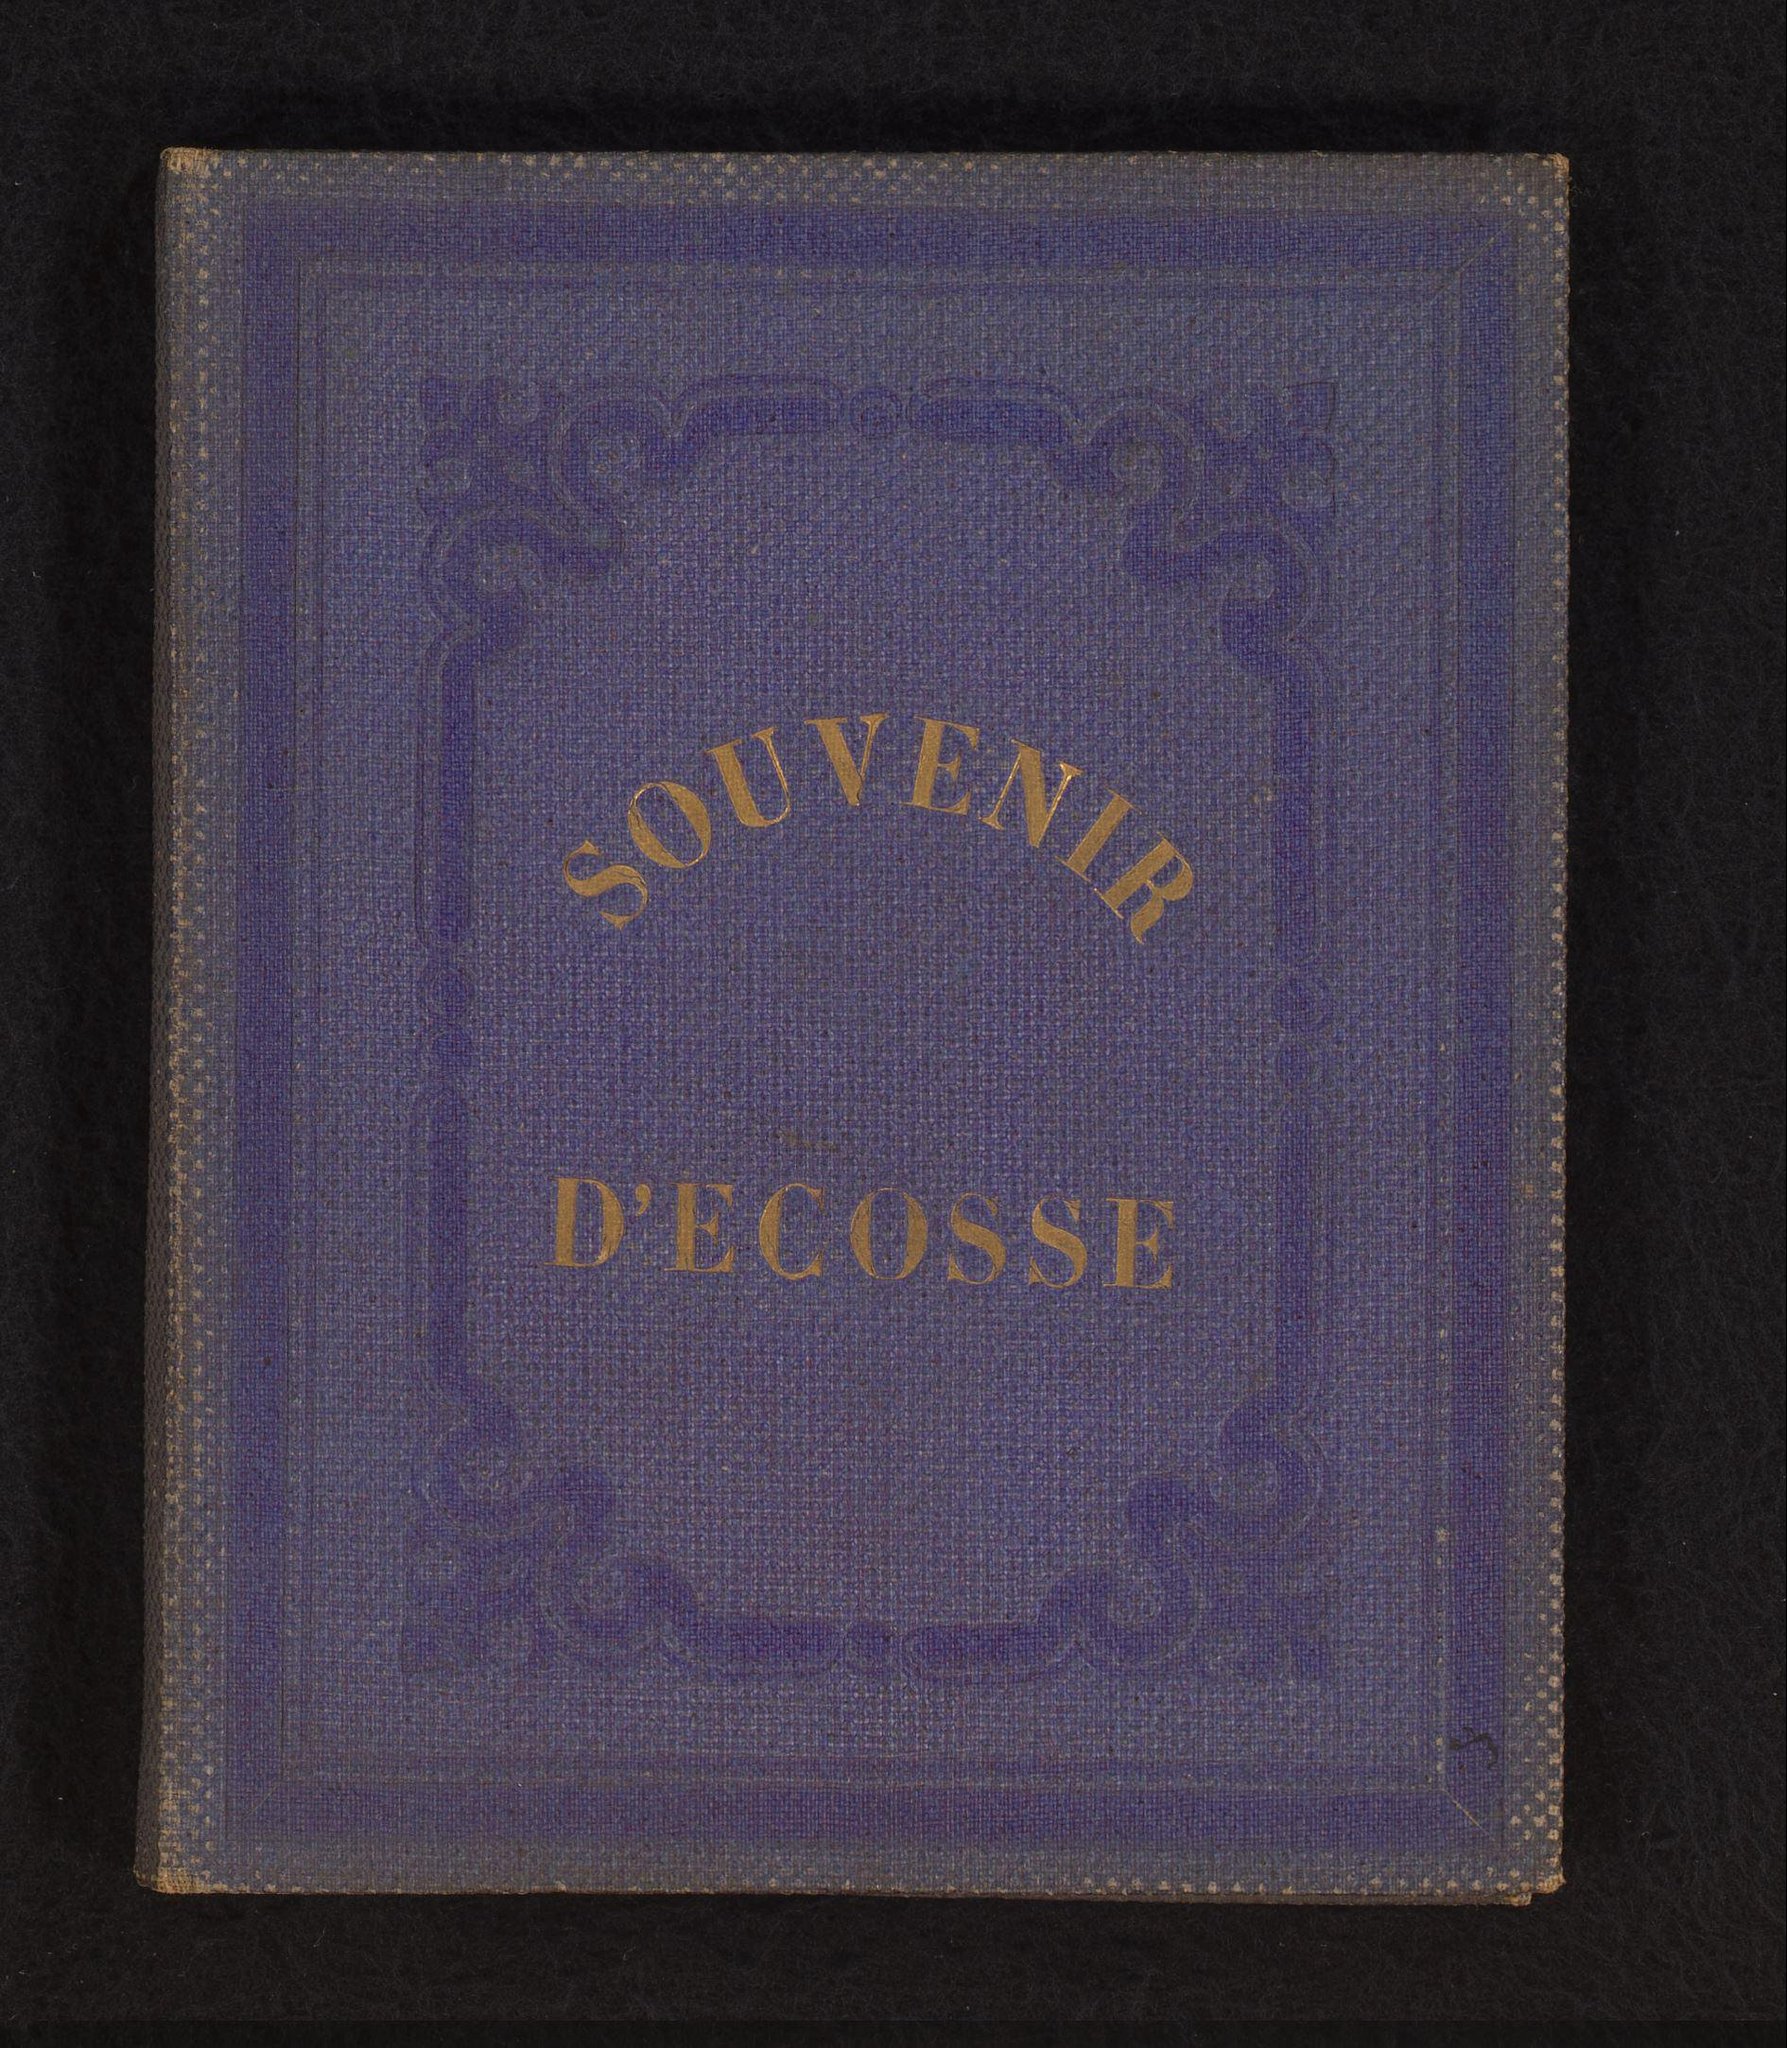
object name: accordion book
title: Leporelloalbum met zeven foto's van Schotland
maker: Anonymous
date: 1860-1880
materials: cardboard, linen, photographic support, tape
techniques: albumen print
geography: scotland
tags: castle, study; 'studiolo'; library, bridge, street, prospect of city, town panorama, silhouette of city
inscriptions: number: ‘125’, collector's mark: ‘DIENST/ VERSPREIDE/ RIJKSKOLLEKTIES/ (...) A 951’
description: Leporelloalbum met zeven gezichten op plaatsen in Schotland. Het album bevat zes aan elkaar vastzittende, kartonnen bladen en een afzonderlijk blad met foto's. In principe zou het album moeten bestaan uit twee leporello's die naar links en naar rechts uitklappen, maar de leporello aan de linkerzijde is incompleet en bevat enkel nog het laatste blad. Afgebeeld zijn onder andere gezichten op Edinburgh, Abbottsford en Balmoral Castle.